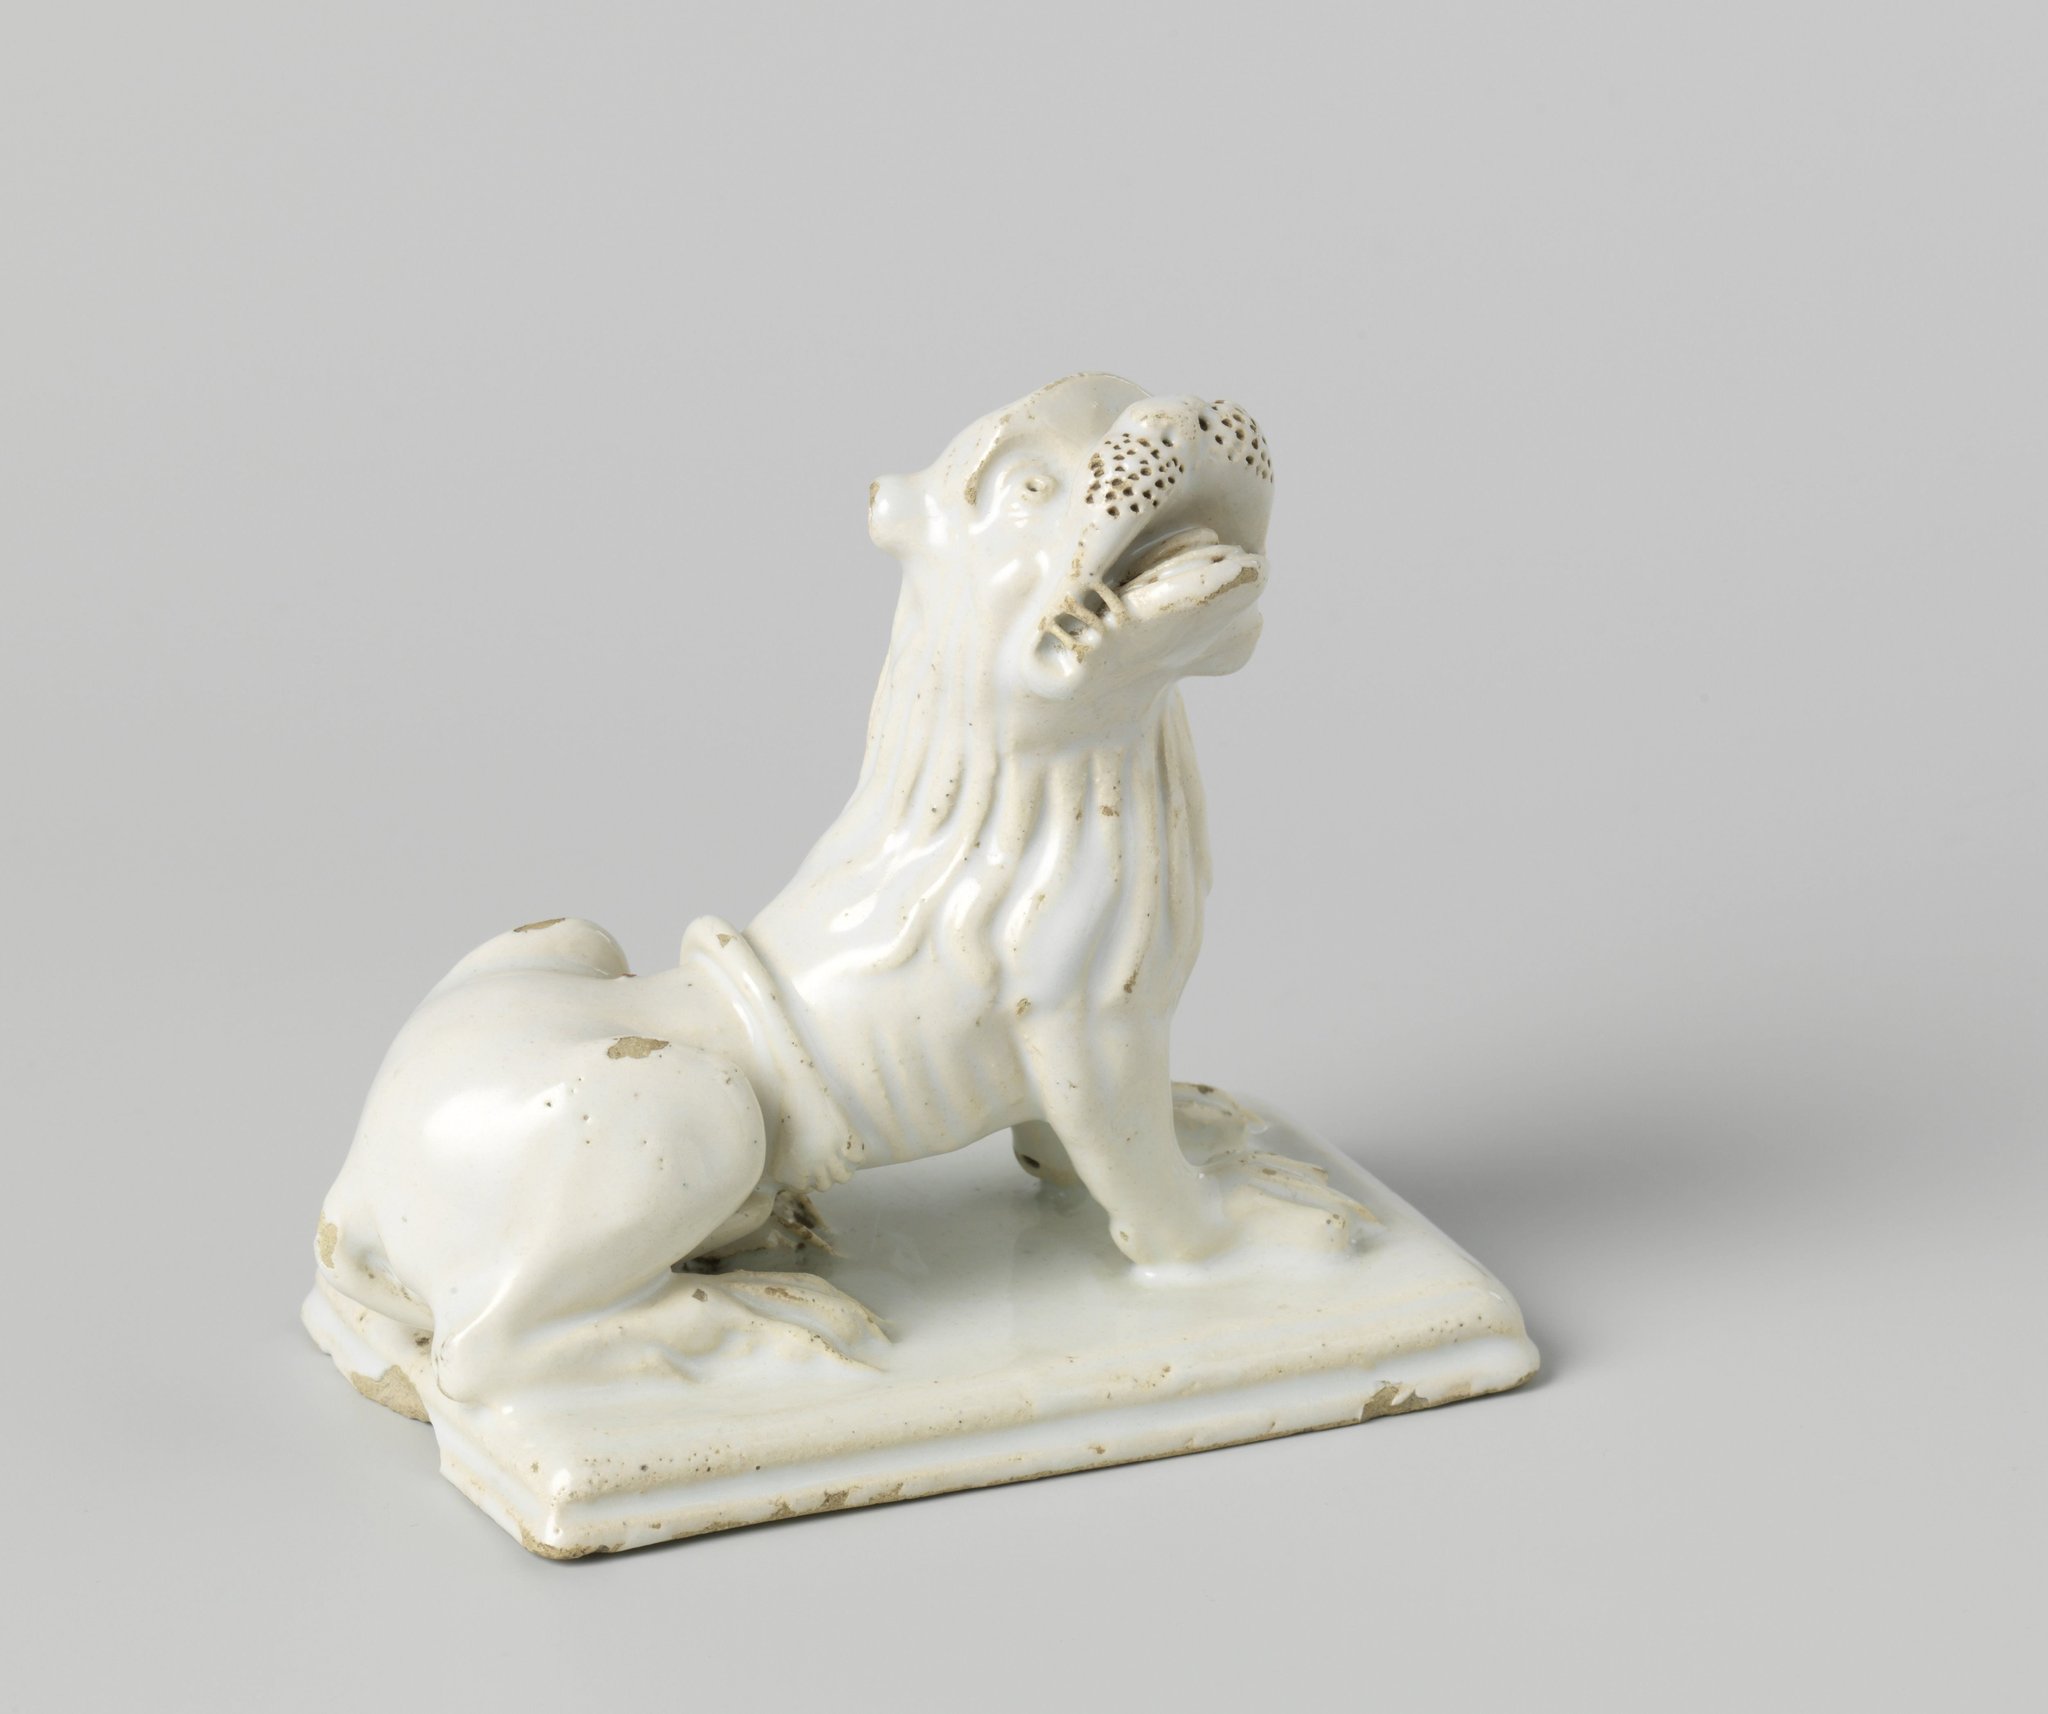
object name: decoratief object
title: Leeuw op rechthoekig geprofileerd voetstuk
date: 1740-1770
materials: earthenware, glaze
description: Beeld van ongedecoreerde faience. Op een rechthoekig geprofileerd voetstuk zit een tempelleeuw met zijn staart over zijn rug geslagen. De leeuw heeft zijn kop naar rechts gewend.